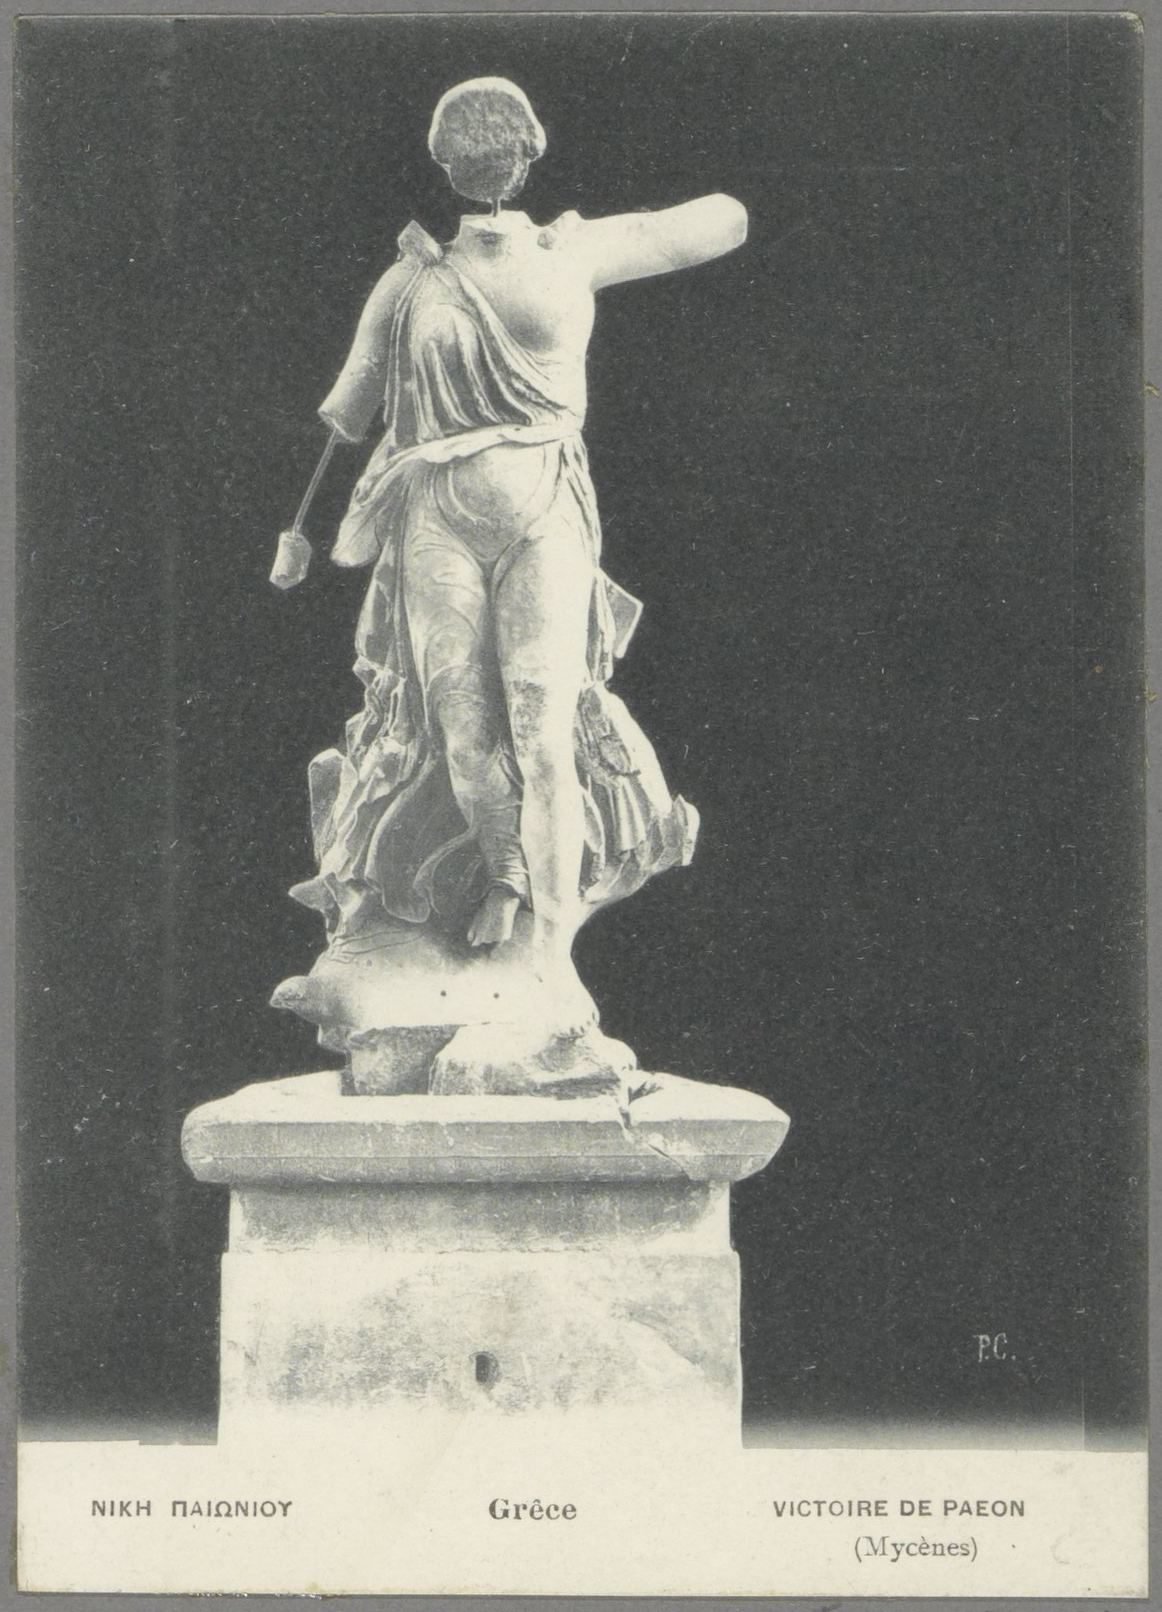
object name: photograph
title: Grêce Victoire de Paeon (Mycènes)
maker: pc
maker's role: fotograaf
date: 1895-1905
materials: paper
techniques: photograph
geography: greece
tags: piece of sculpture, reproduction of a piece of sculpture, (story of) nike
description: Onderdeel van Reisalbum met foto's van bezienswaardigheden in Griekenland en Egypte.